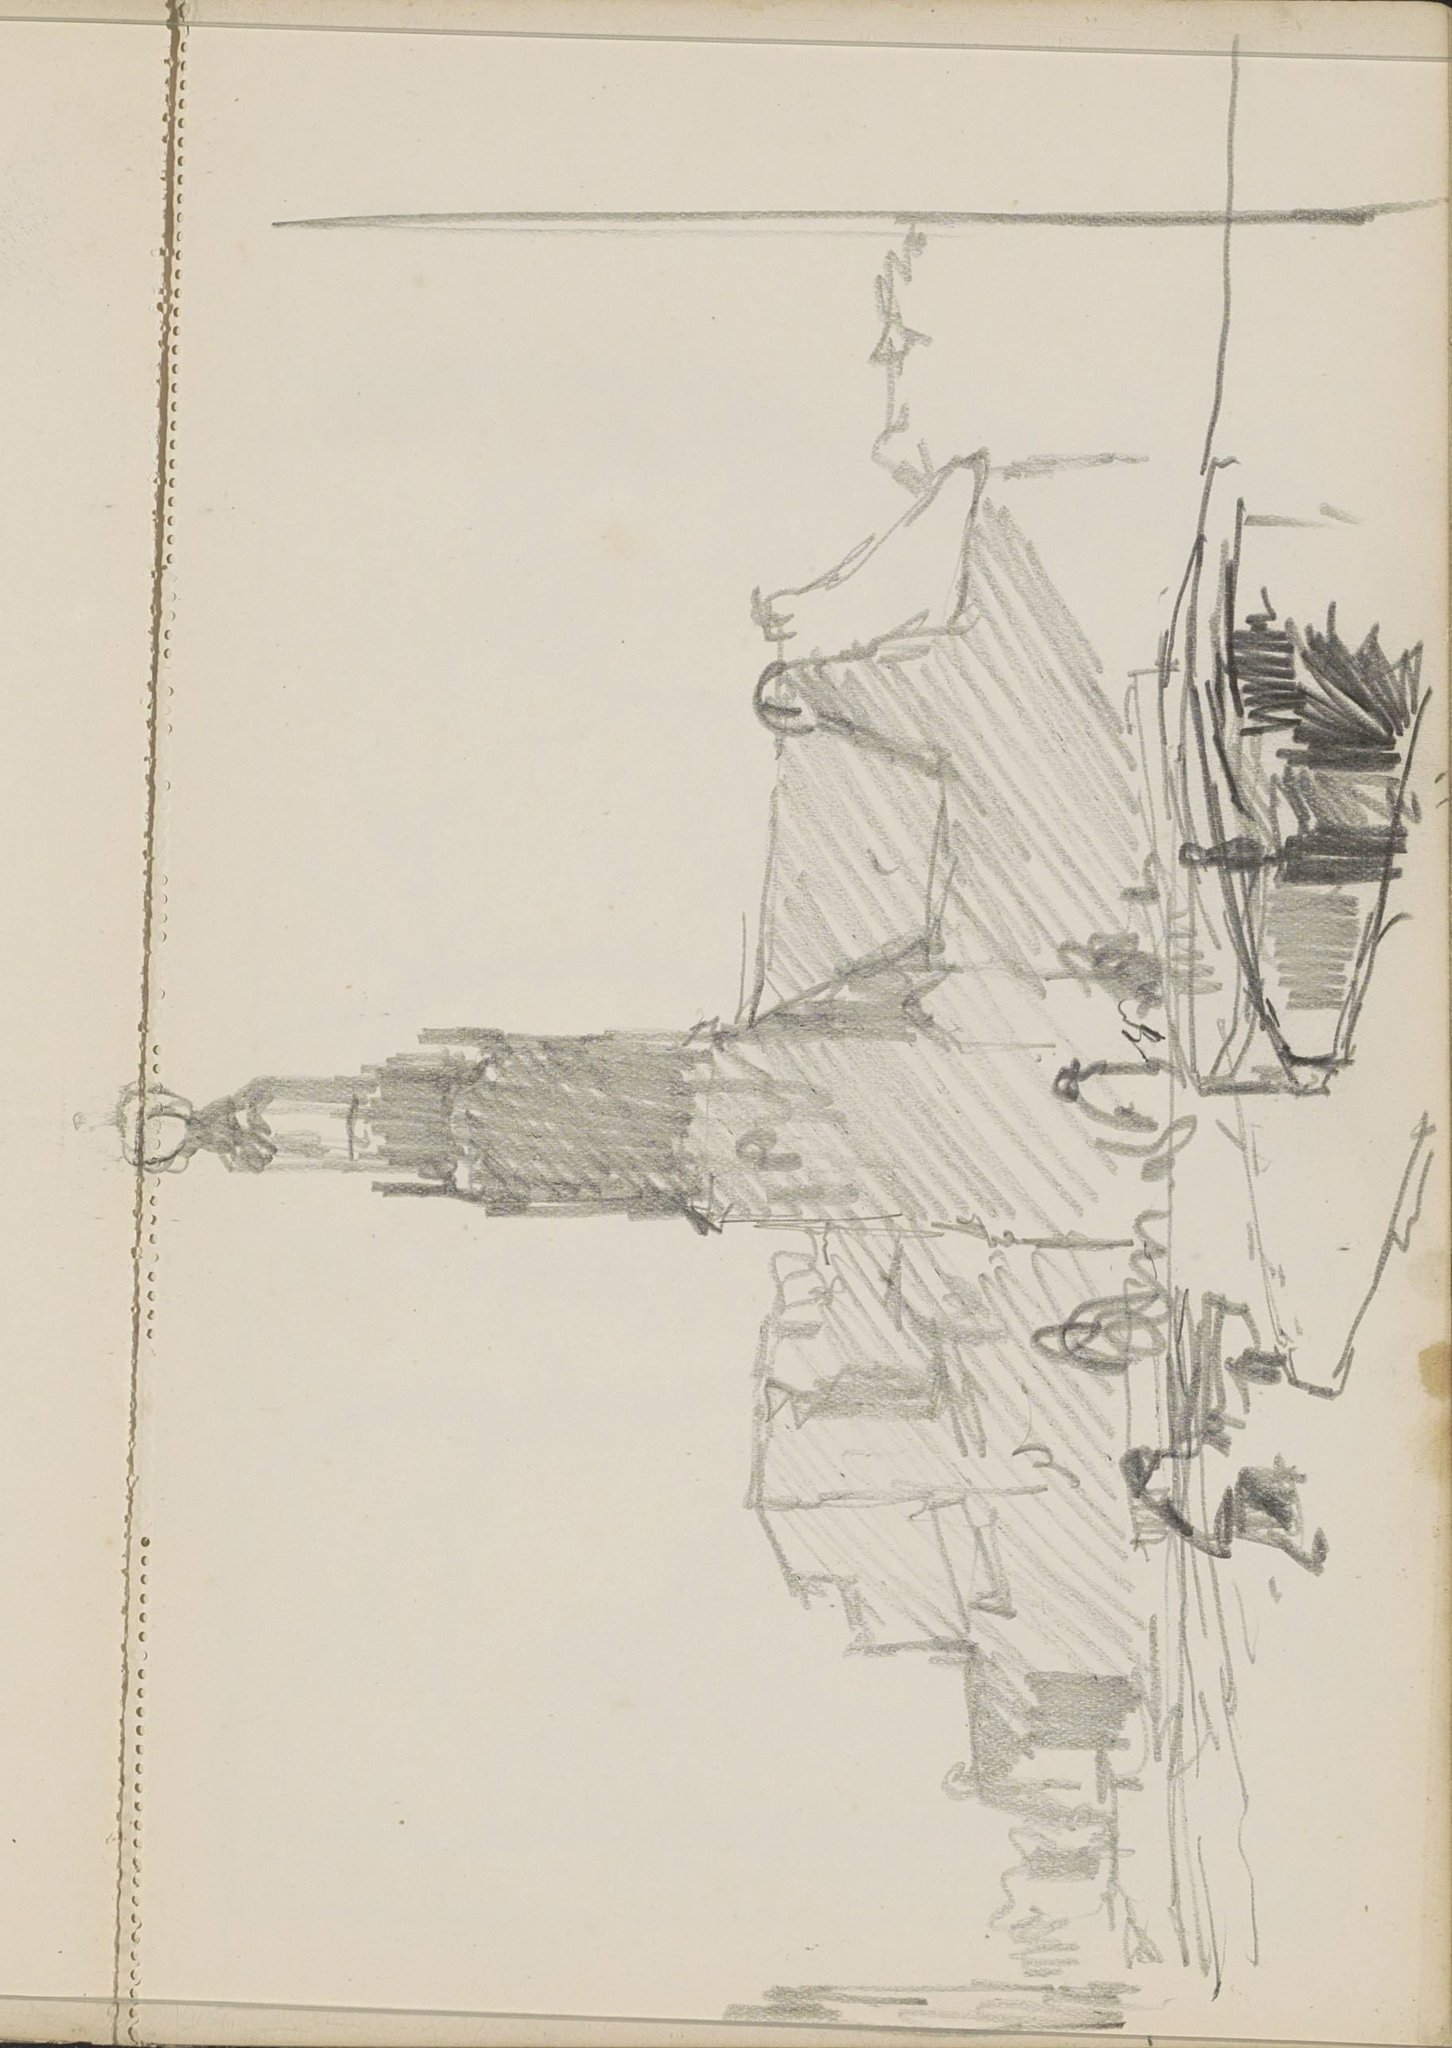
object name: sketchbook leaf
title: Kerk bij een brug over een gracht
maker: cornelis vreedenburgh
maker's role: draughtsman, print maker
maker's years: 1880-1946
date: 1890-1946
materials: paper, pencil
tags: church (exterior), bridge in city across river, canal, etc.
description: Blad 47 recto uit een schetsboek met 59 bladen.